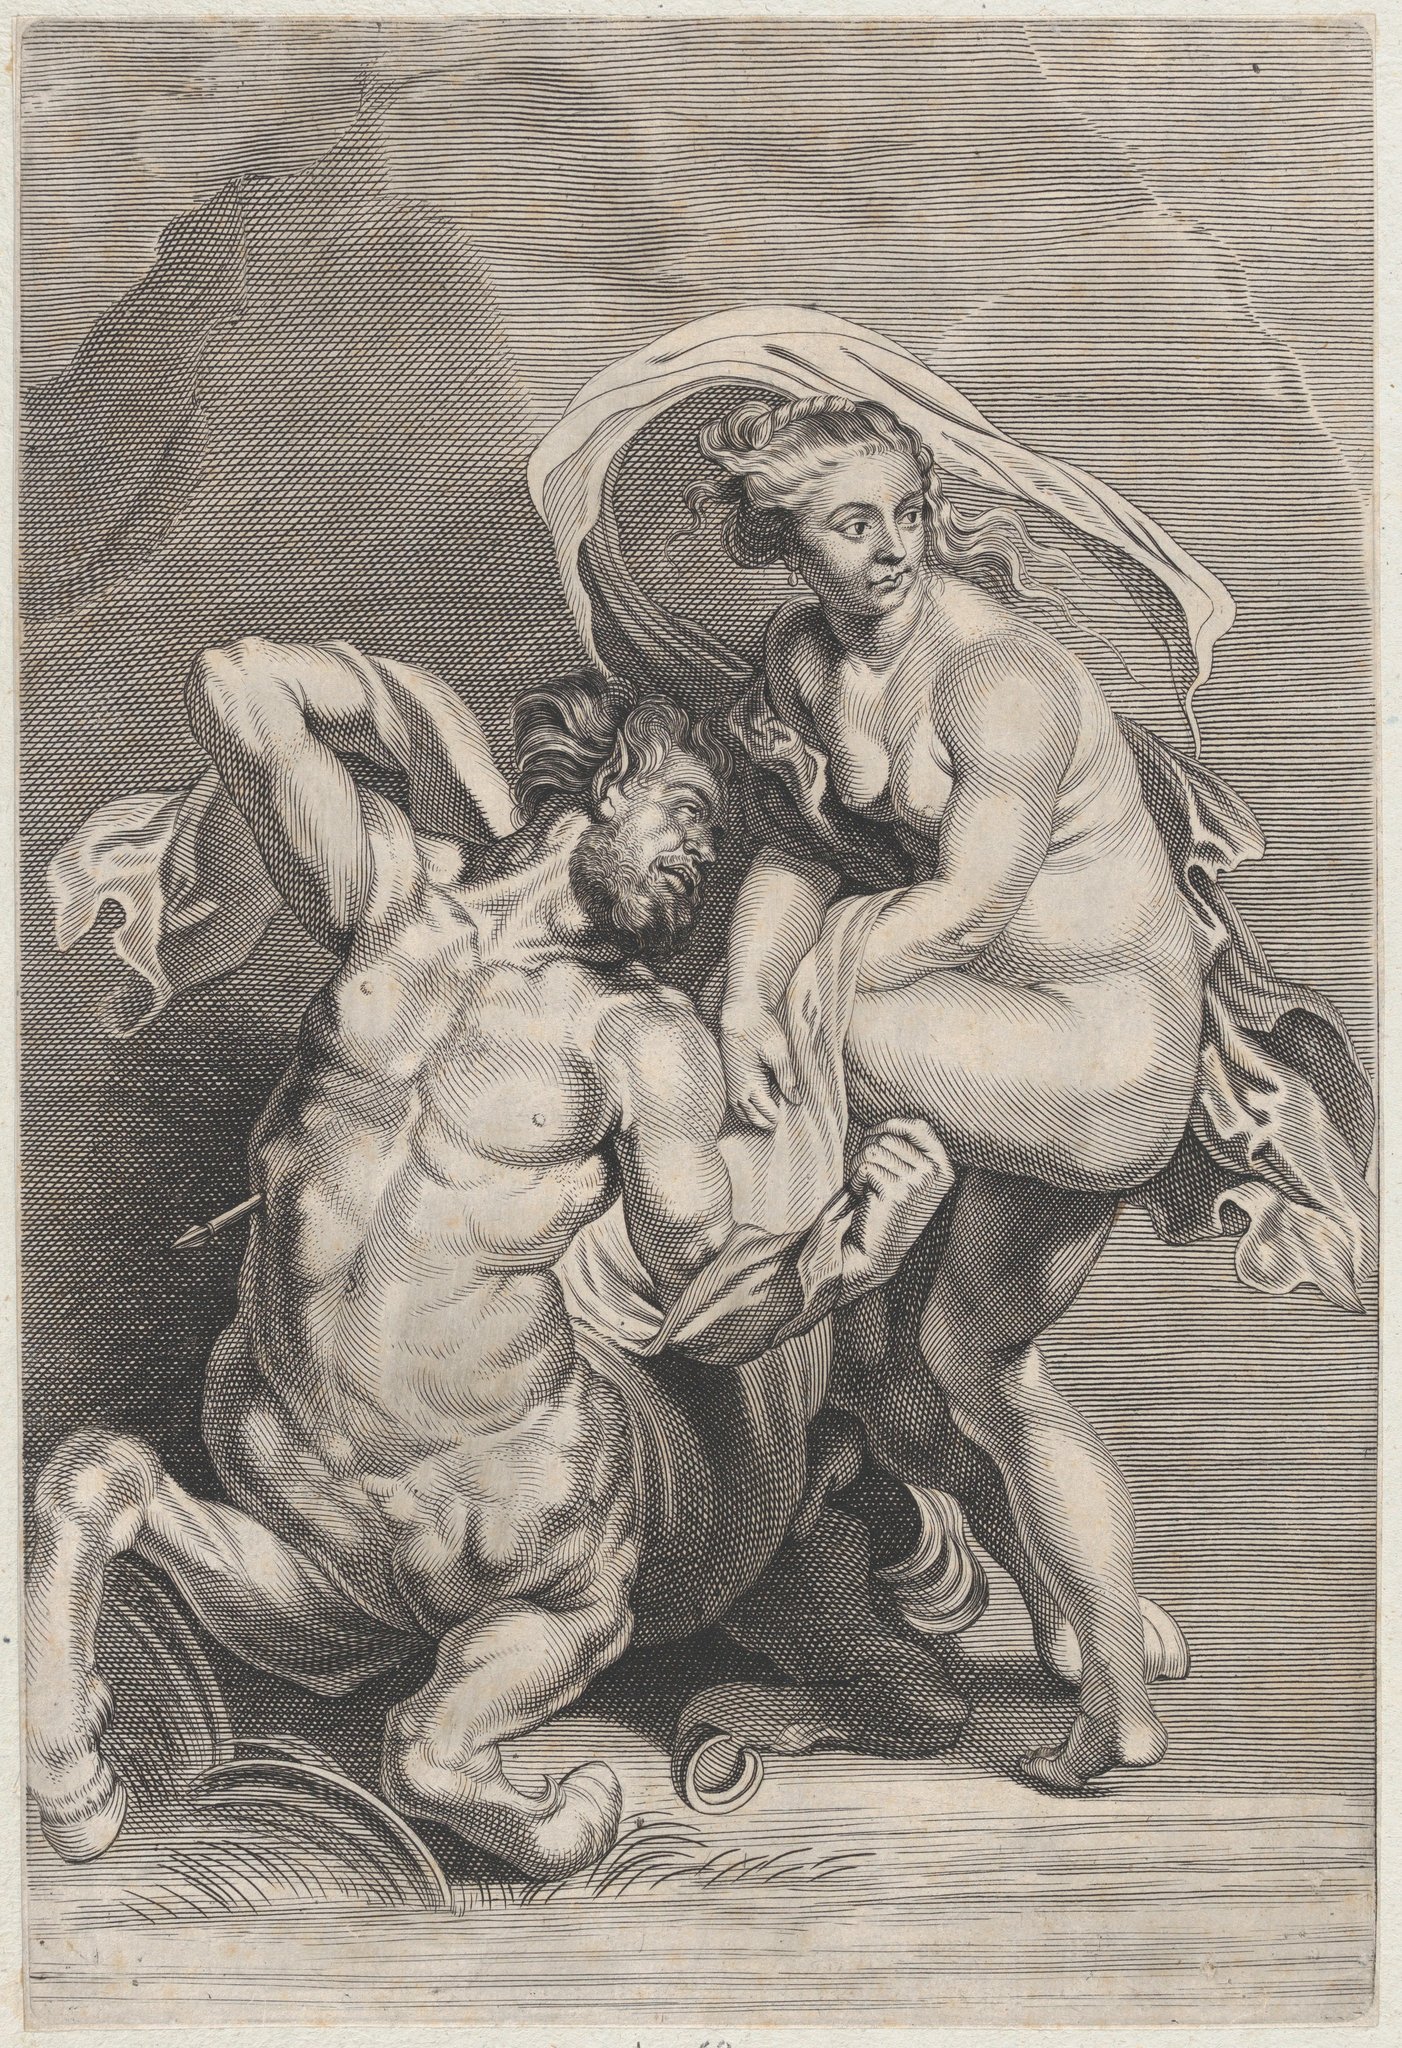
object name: print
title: Deianeira receiving the poisoned tunic from Nessus, and the wounded centaur falling to the ground at left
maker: Anonymous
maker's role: artist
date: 1650-1700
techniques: engraving